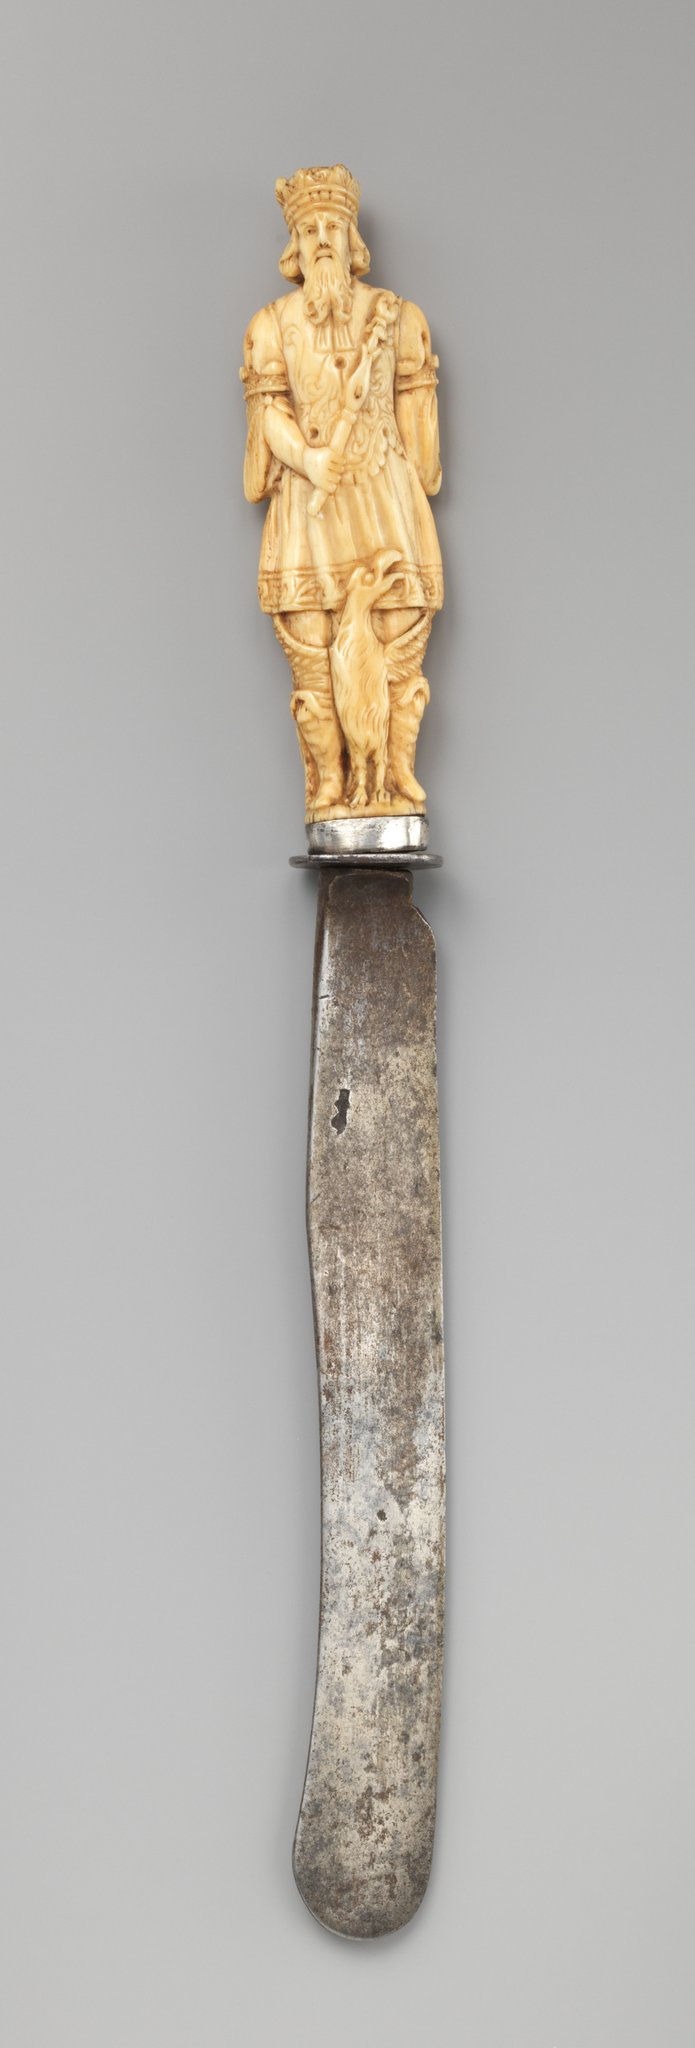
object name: table knife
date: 1601-1700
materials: ivory, steel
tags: eagles,men